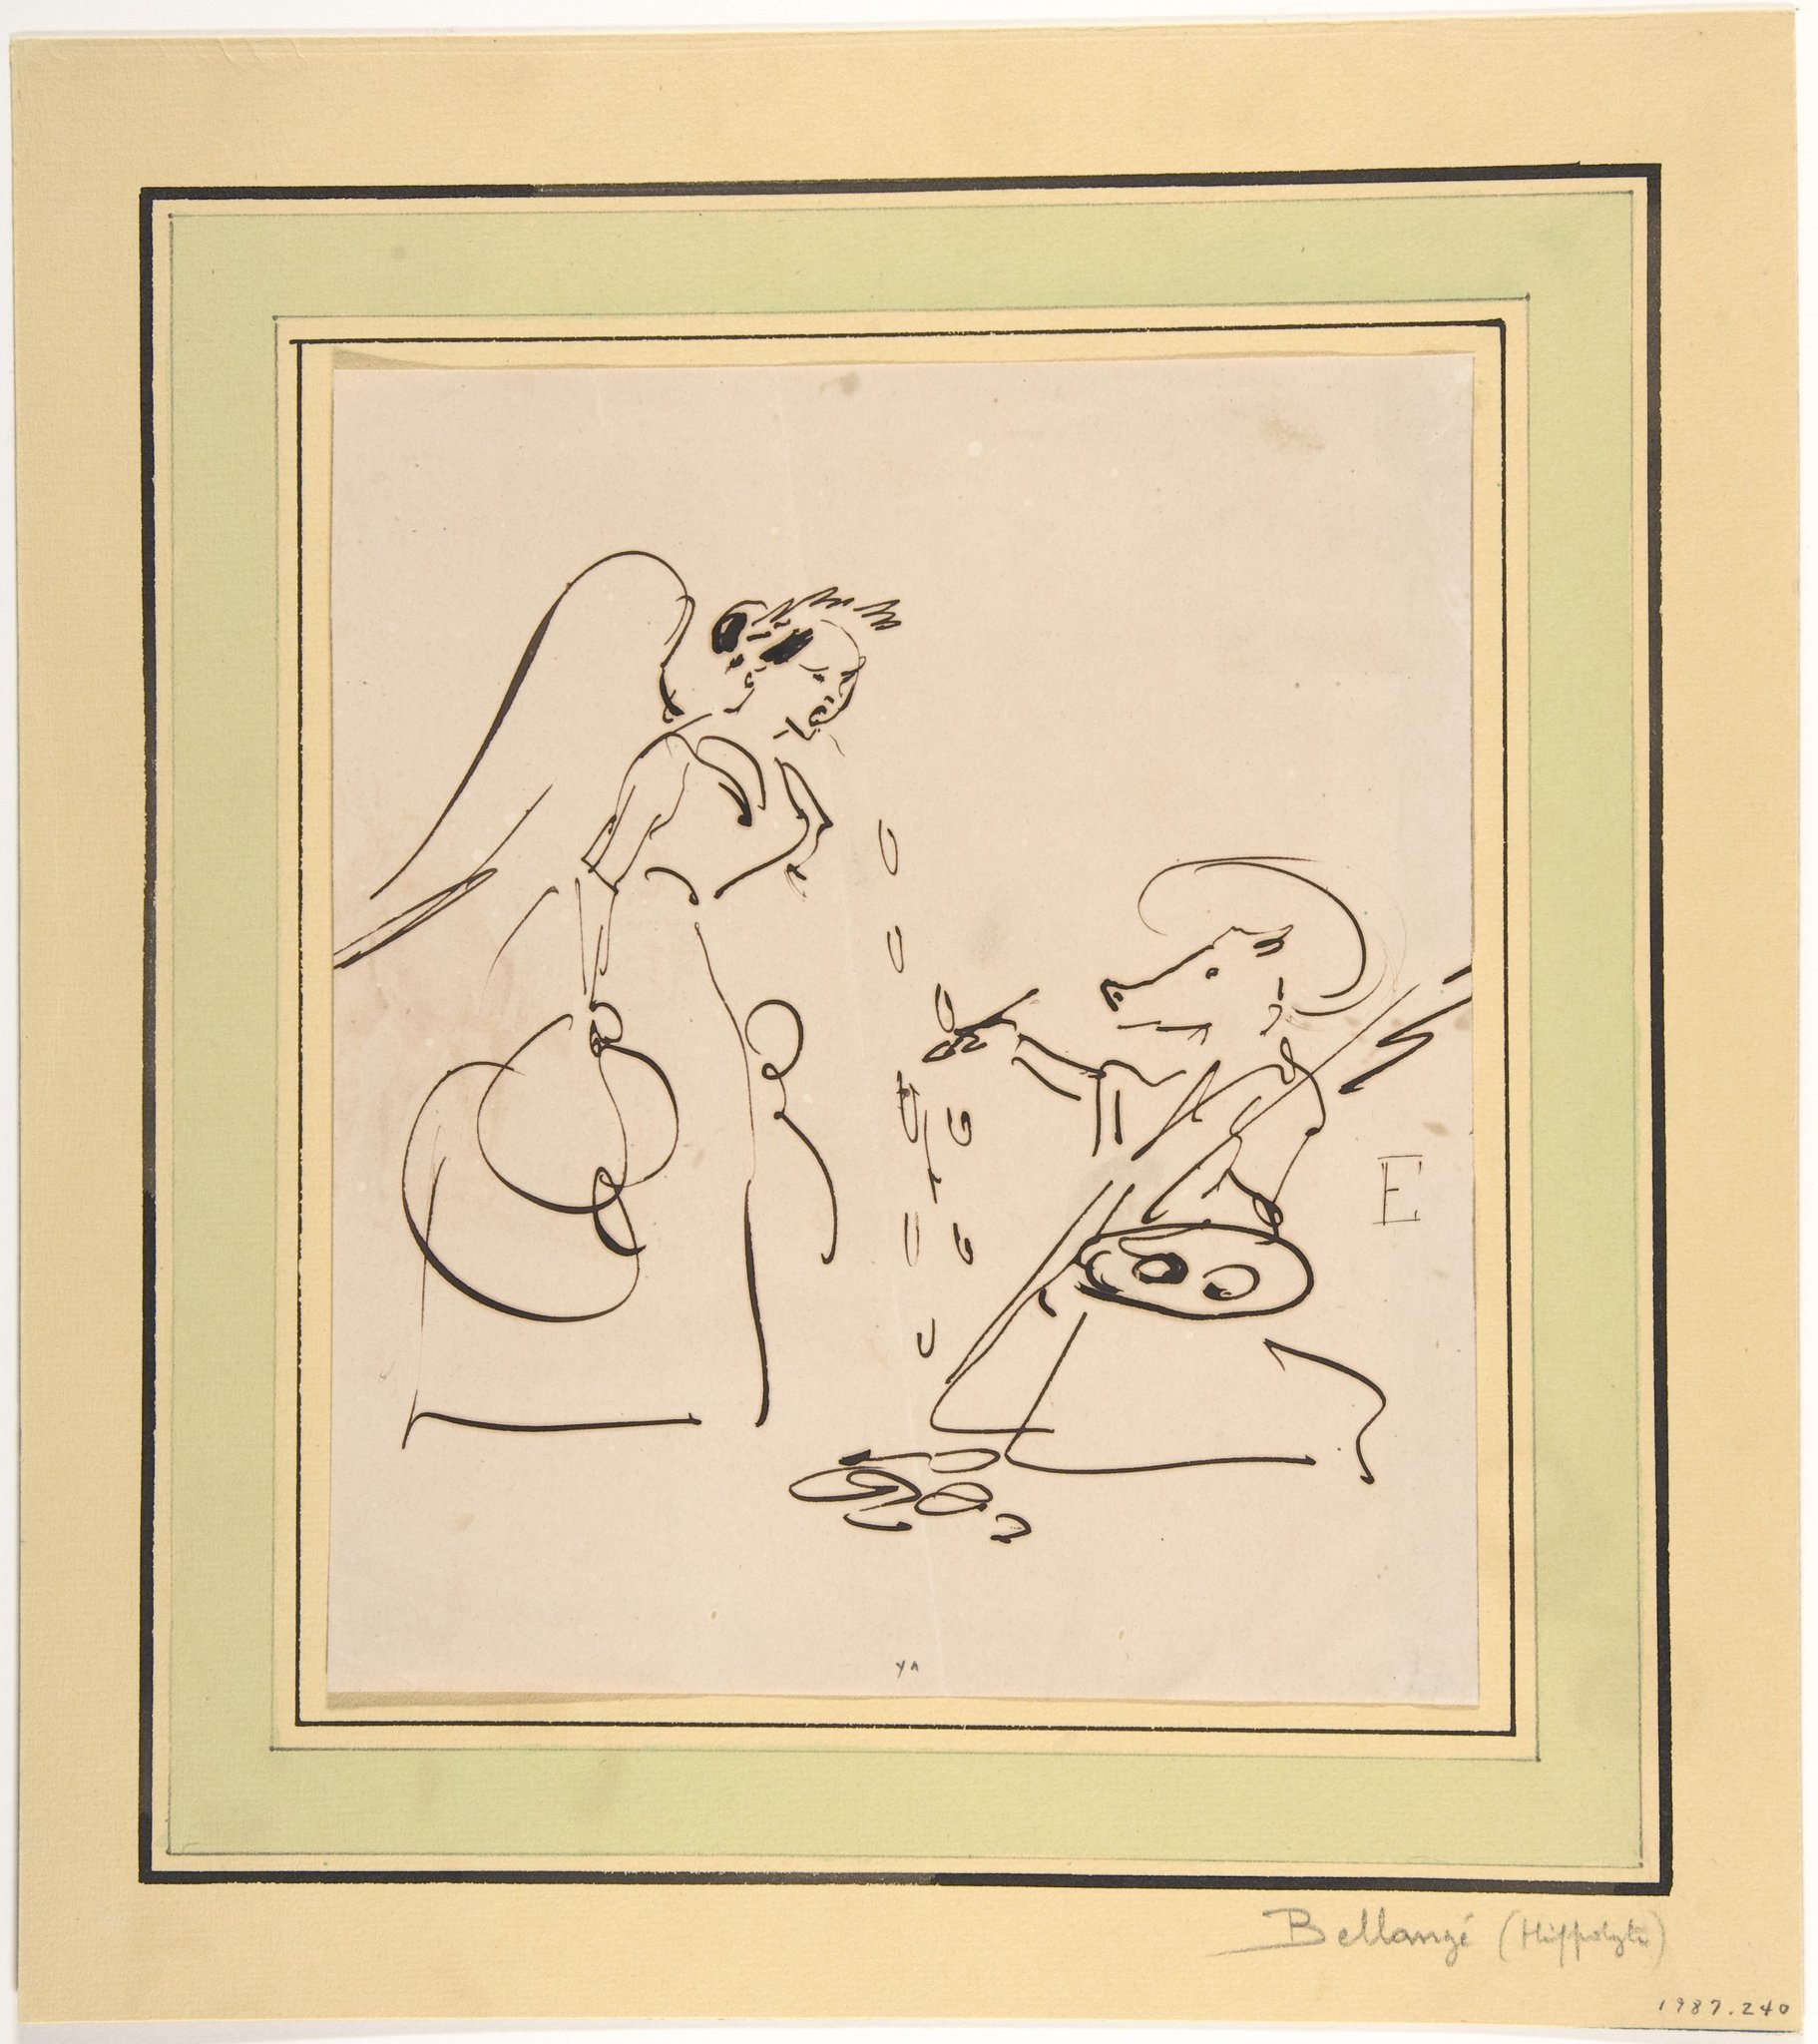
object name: drawing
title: Caricature of the Art of Painting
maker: hippolyte bellangé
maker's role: artist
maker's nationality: french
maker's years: 1800-1866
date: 1800-1866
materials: ink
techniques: pen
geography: france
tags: painting